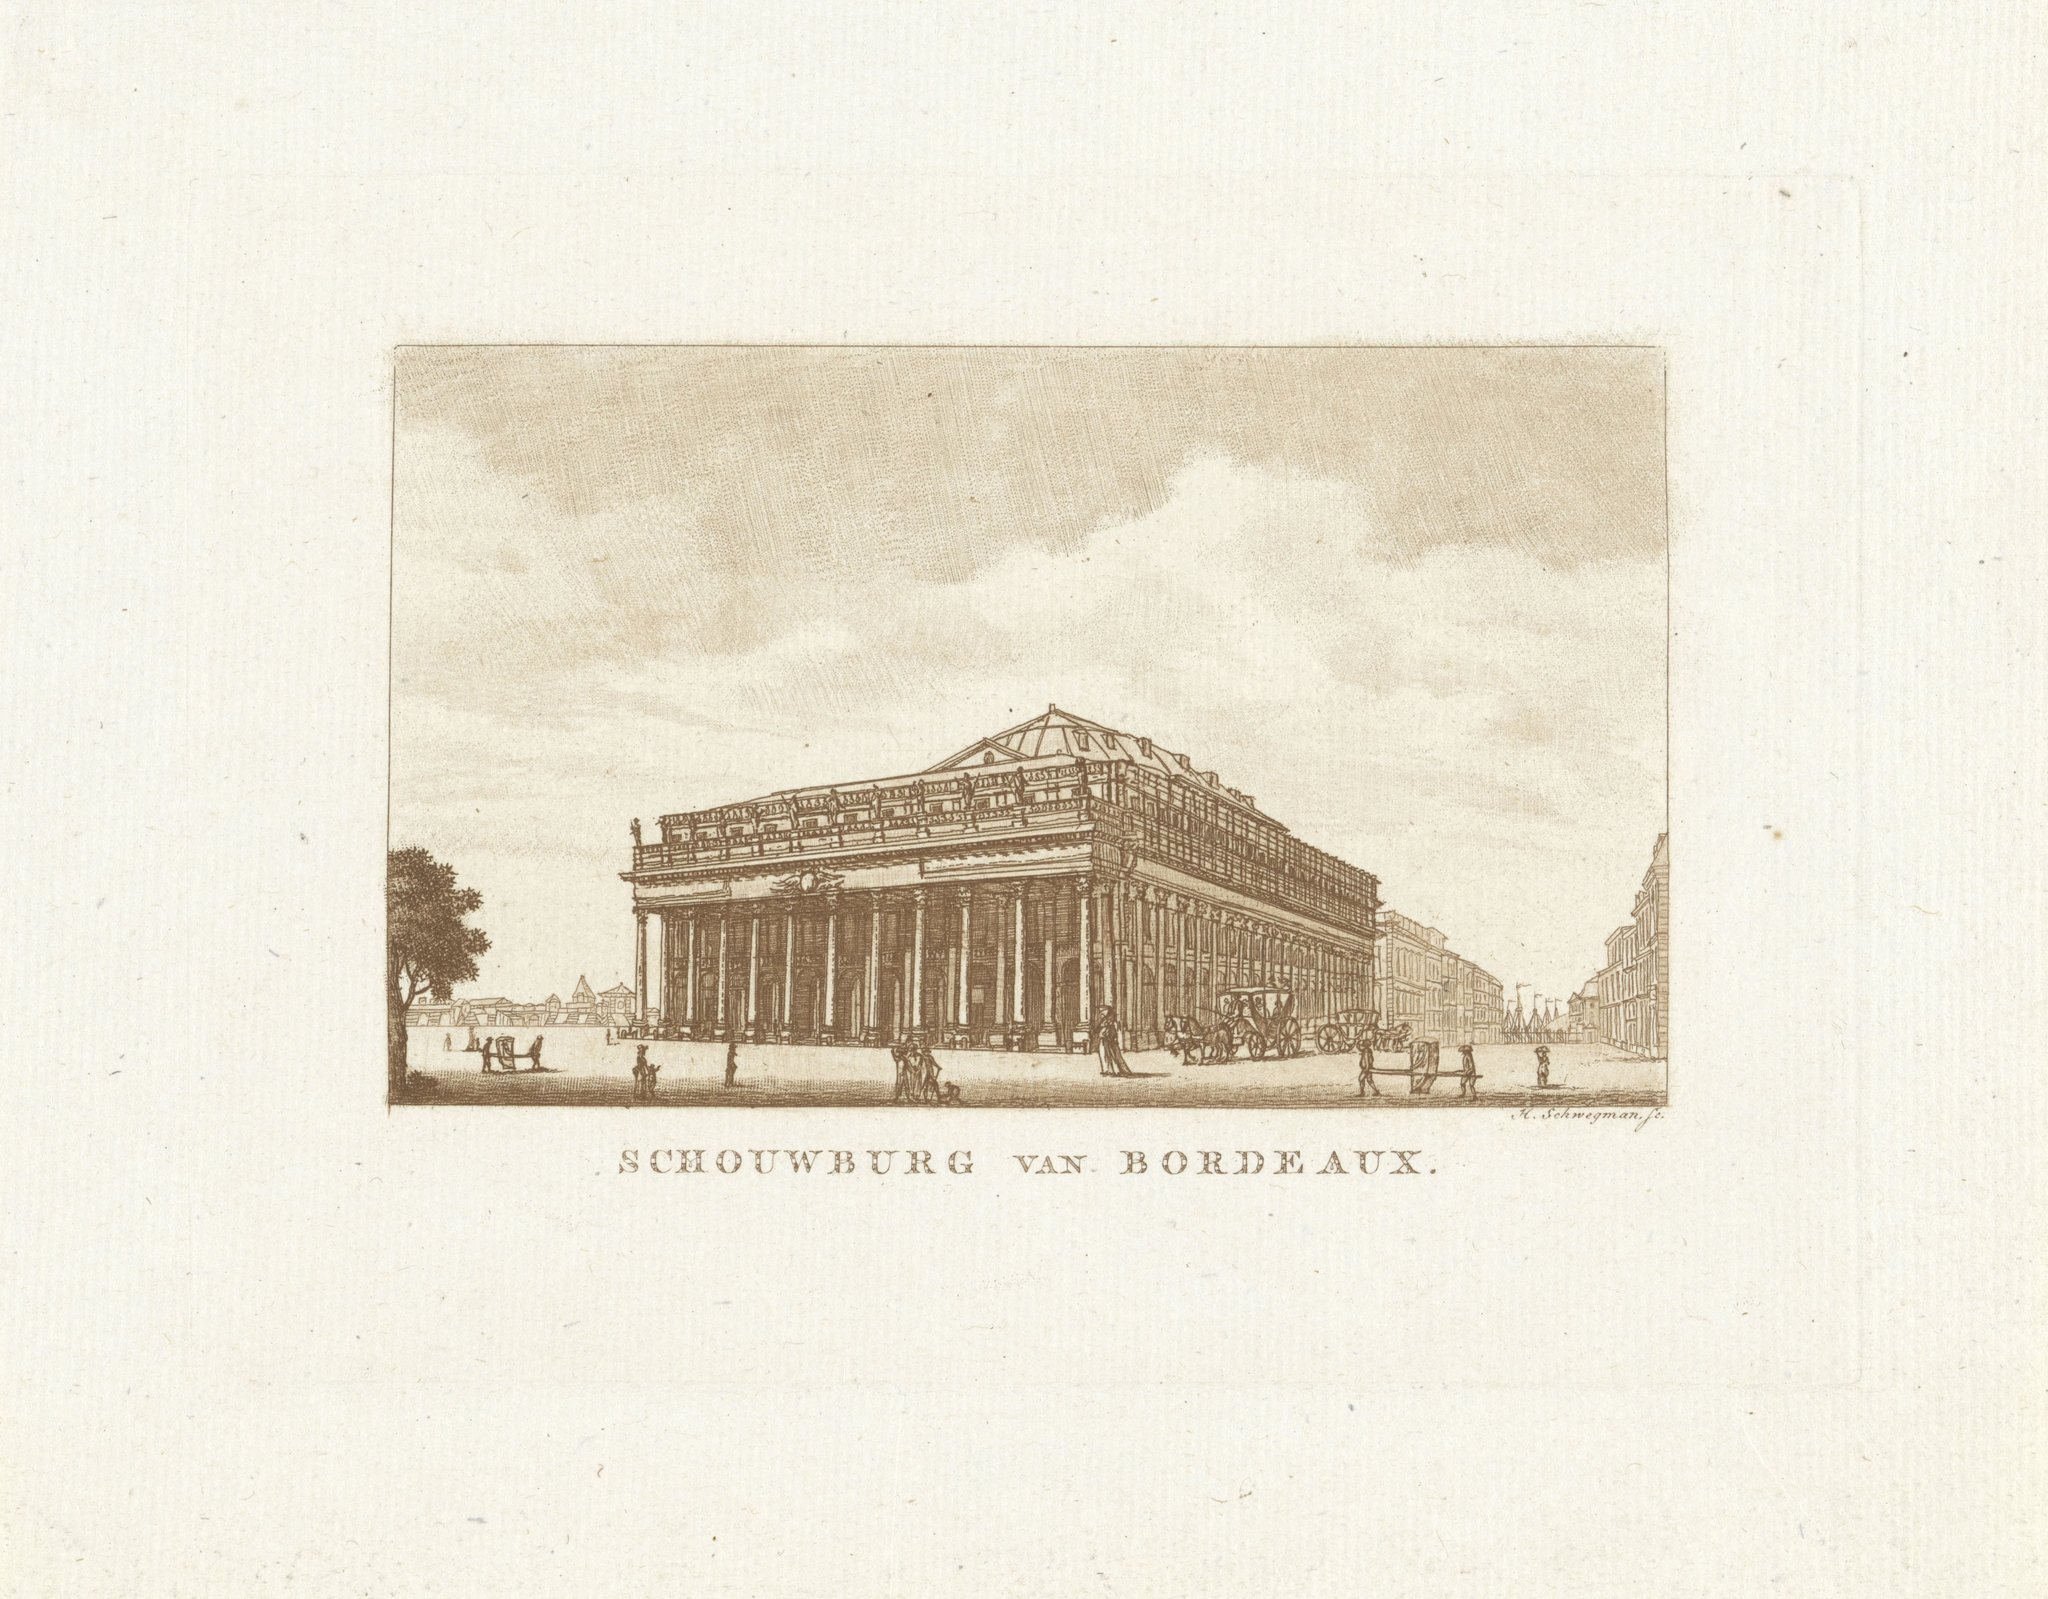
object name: print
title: Schouwburg van Bordeaux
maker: hendrik schwegman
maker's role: draughtsman, print maker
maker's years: 1761-1816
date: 1771-1816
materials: paper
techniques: etching, roulette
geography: haarlem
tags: theatre (building)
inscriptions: collector's mark: Lugt 2228